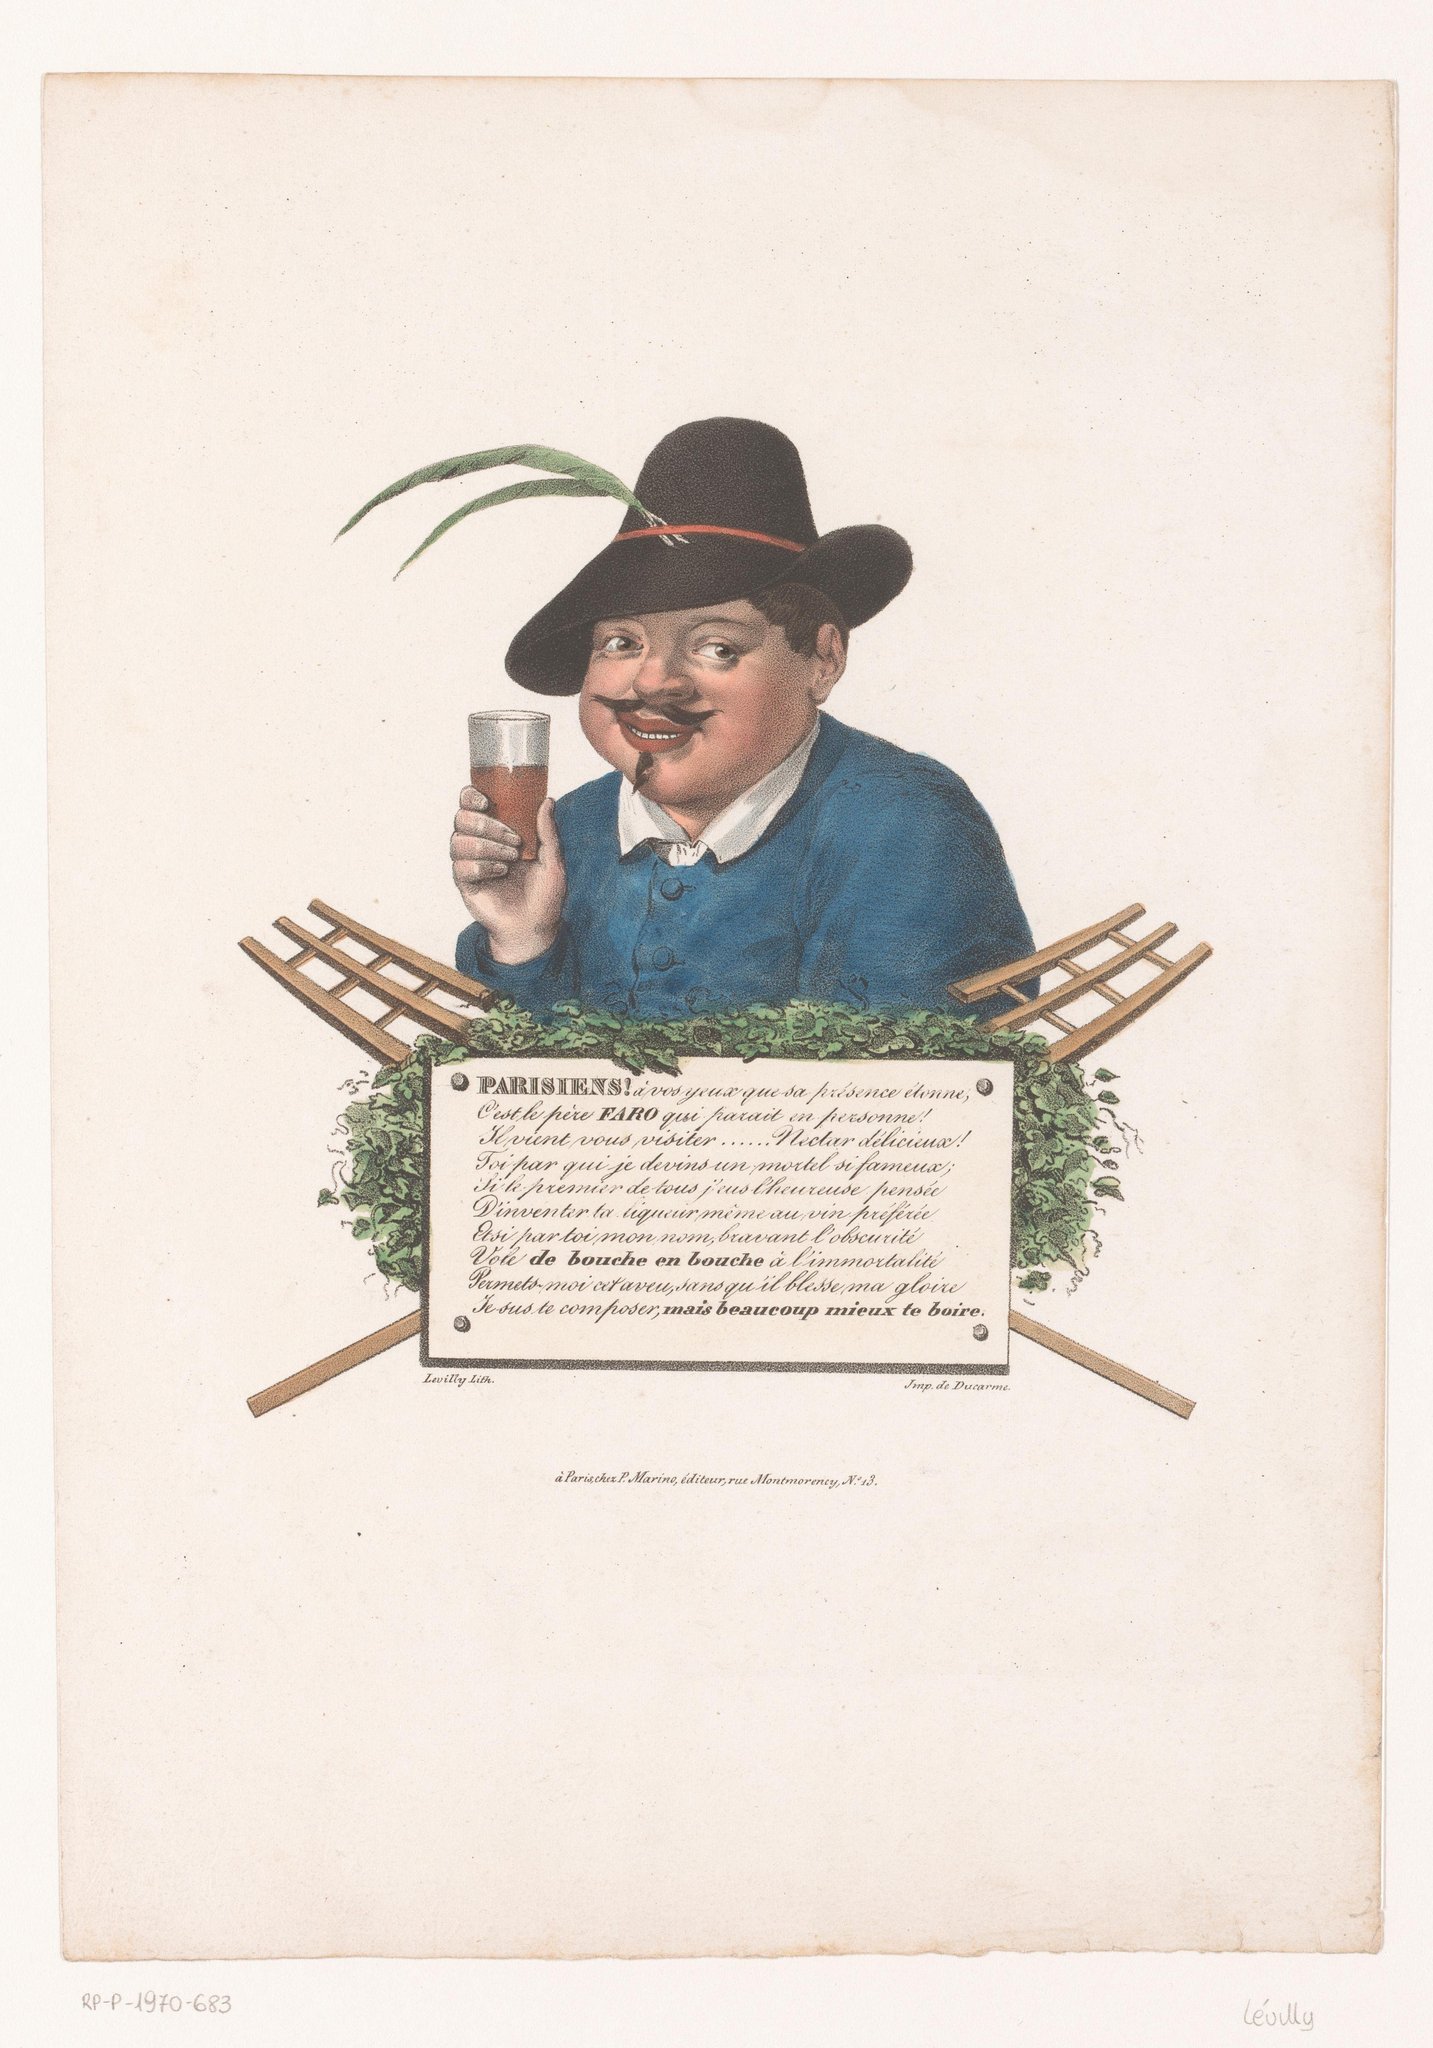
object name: print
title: Man met glas Faro (bier)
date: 1827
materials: paper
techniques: hand coloring, lithograph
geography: paris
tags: adult man, beer, ale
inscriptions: collector's mark: Lugt 2228